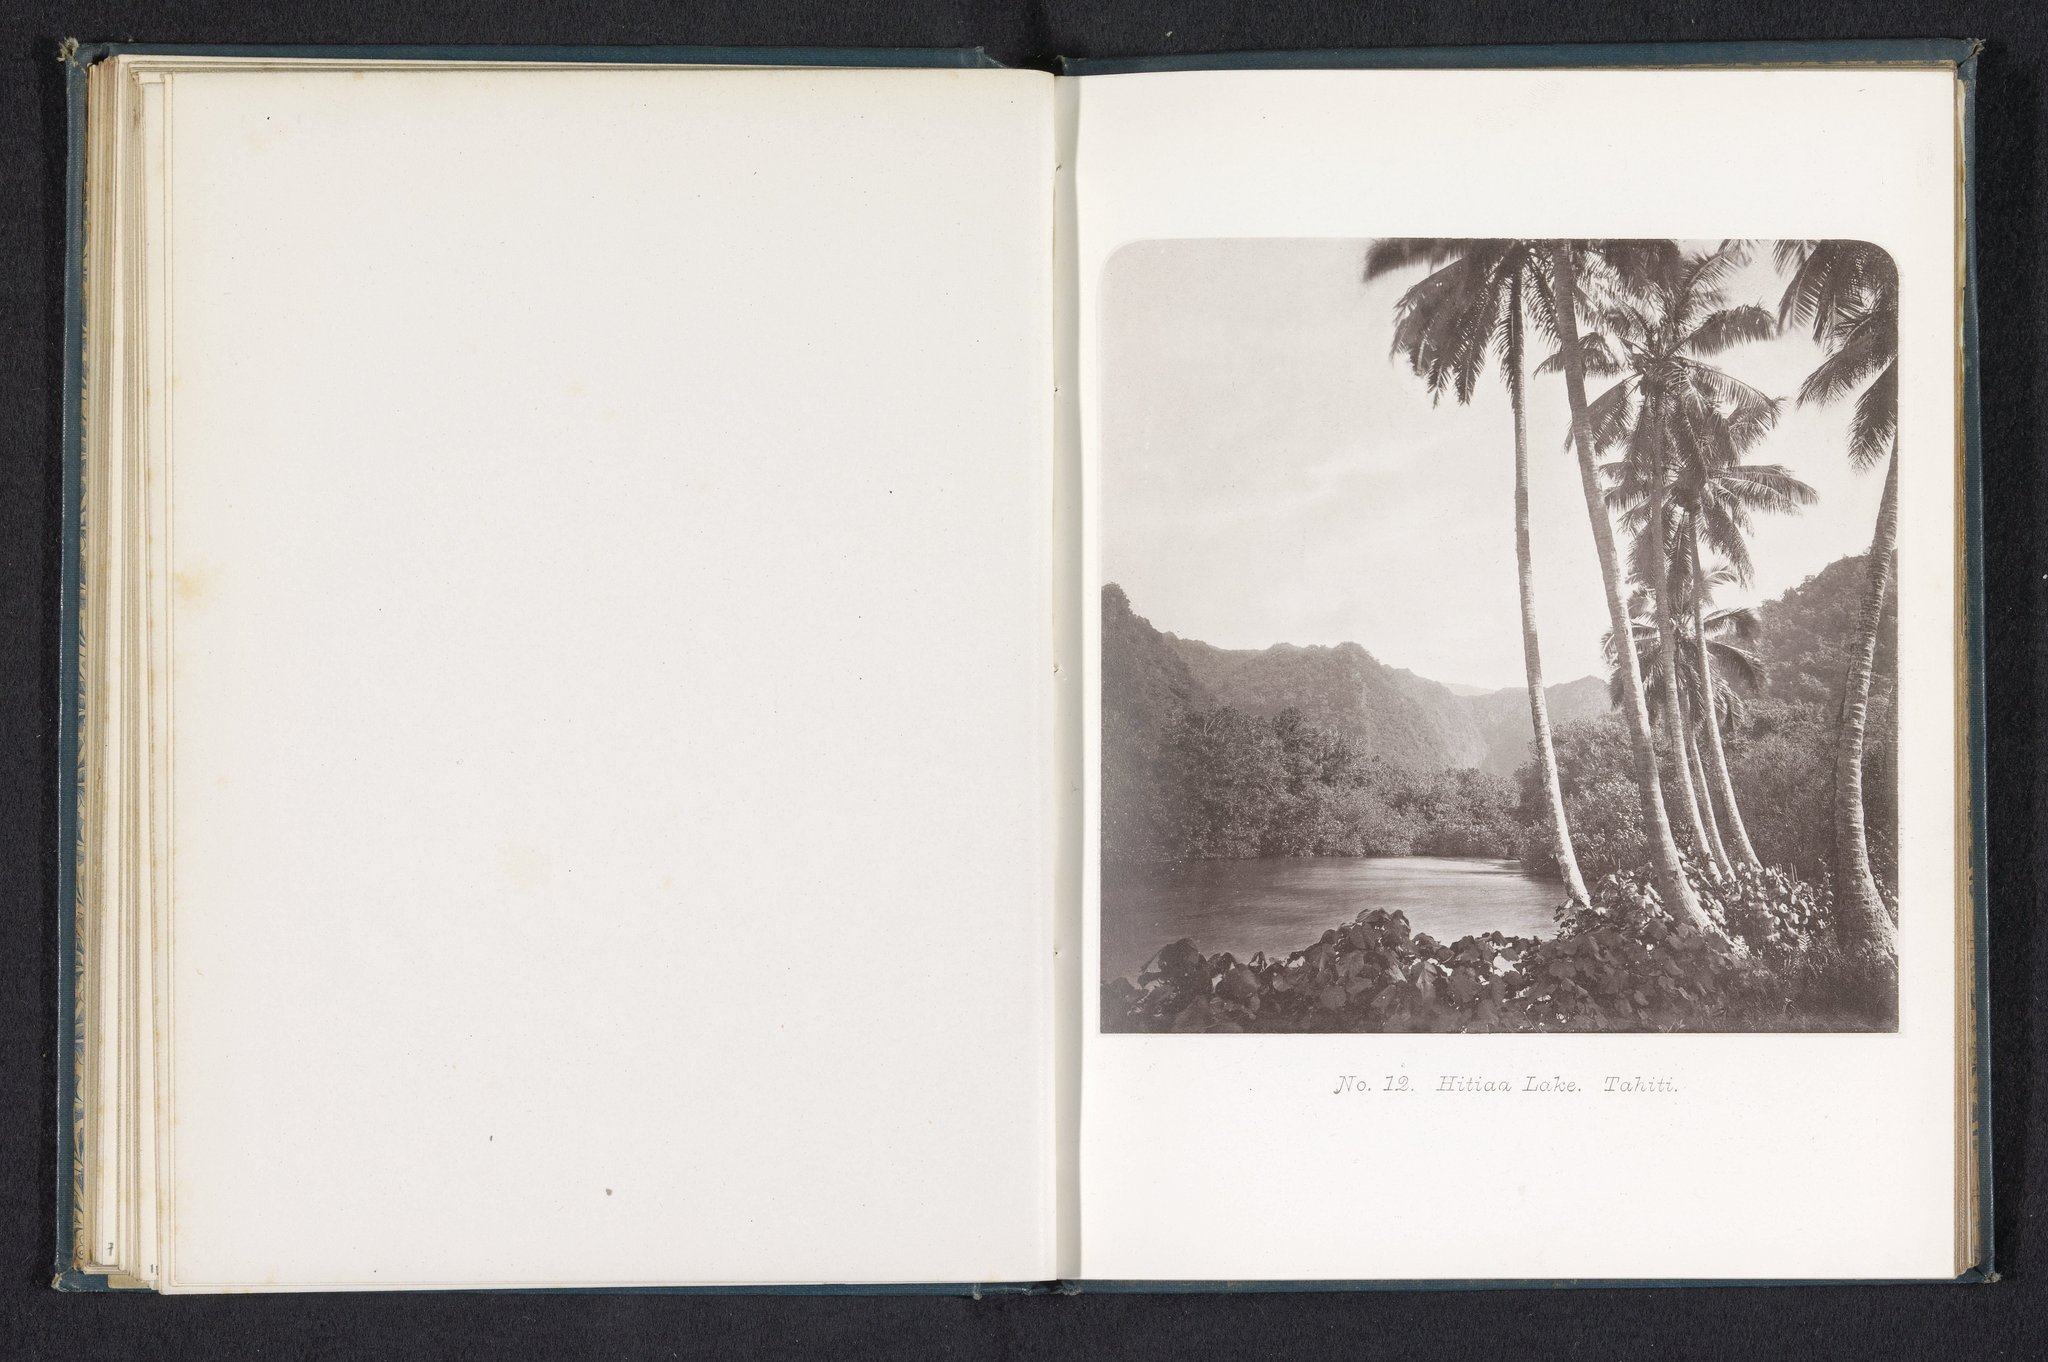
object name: page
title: Hitiaa Lake. Tahiti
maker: henry stuart-wortley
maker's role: fotograaf, kolonel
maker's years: 1832-1890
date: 1880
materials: paper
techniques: photograph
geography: tahiti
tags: lake, trees: palm-tree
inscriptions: number: ‘No. 12.’